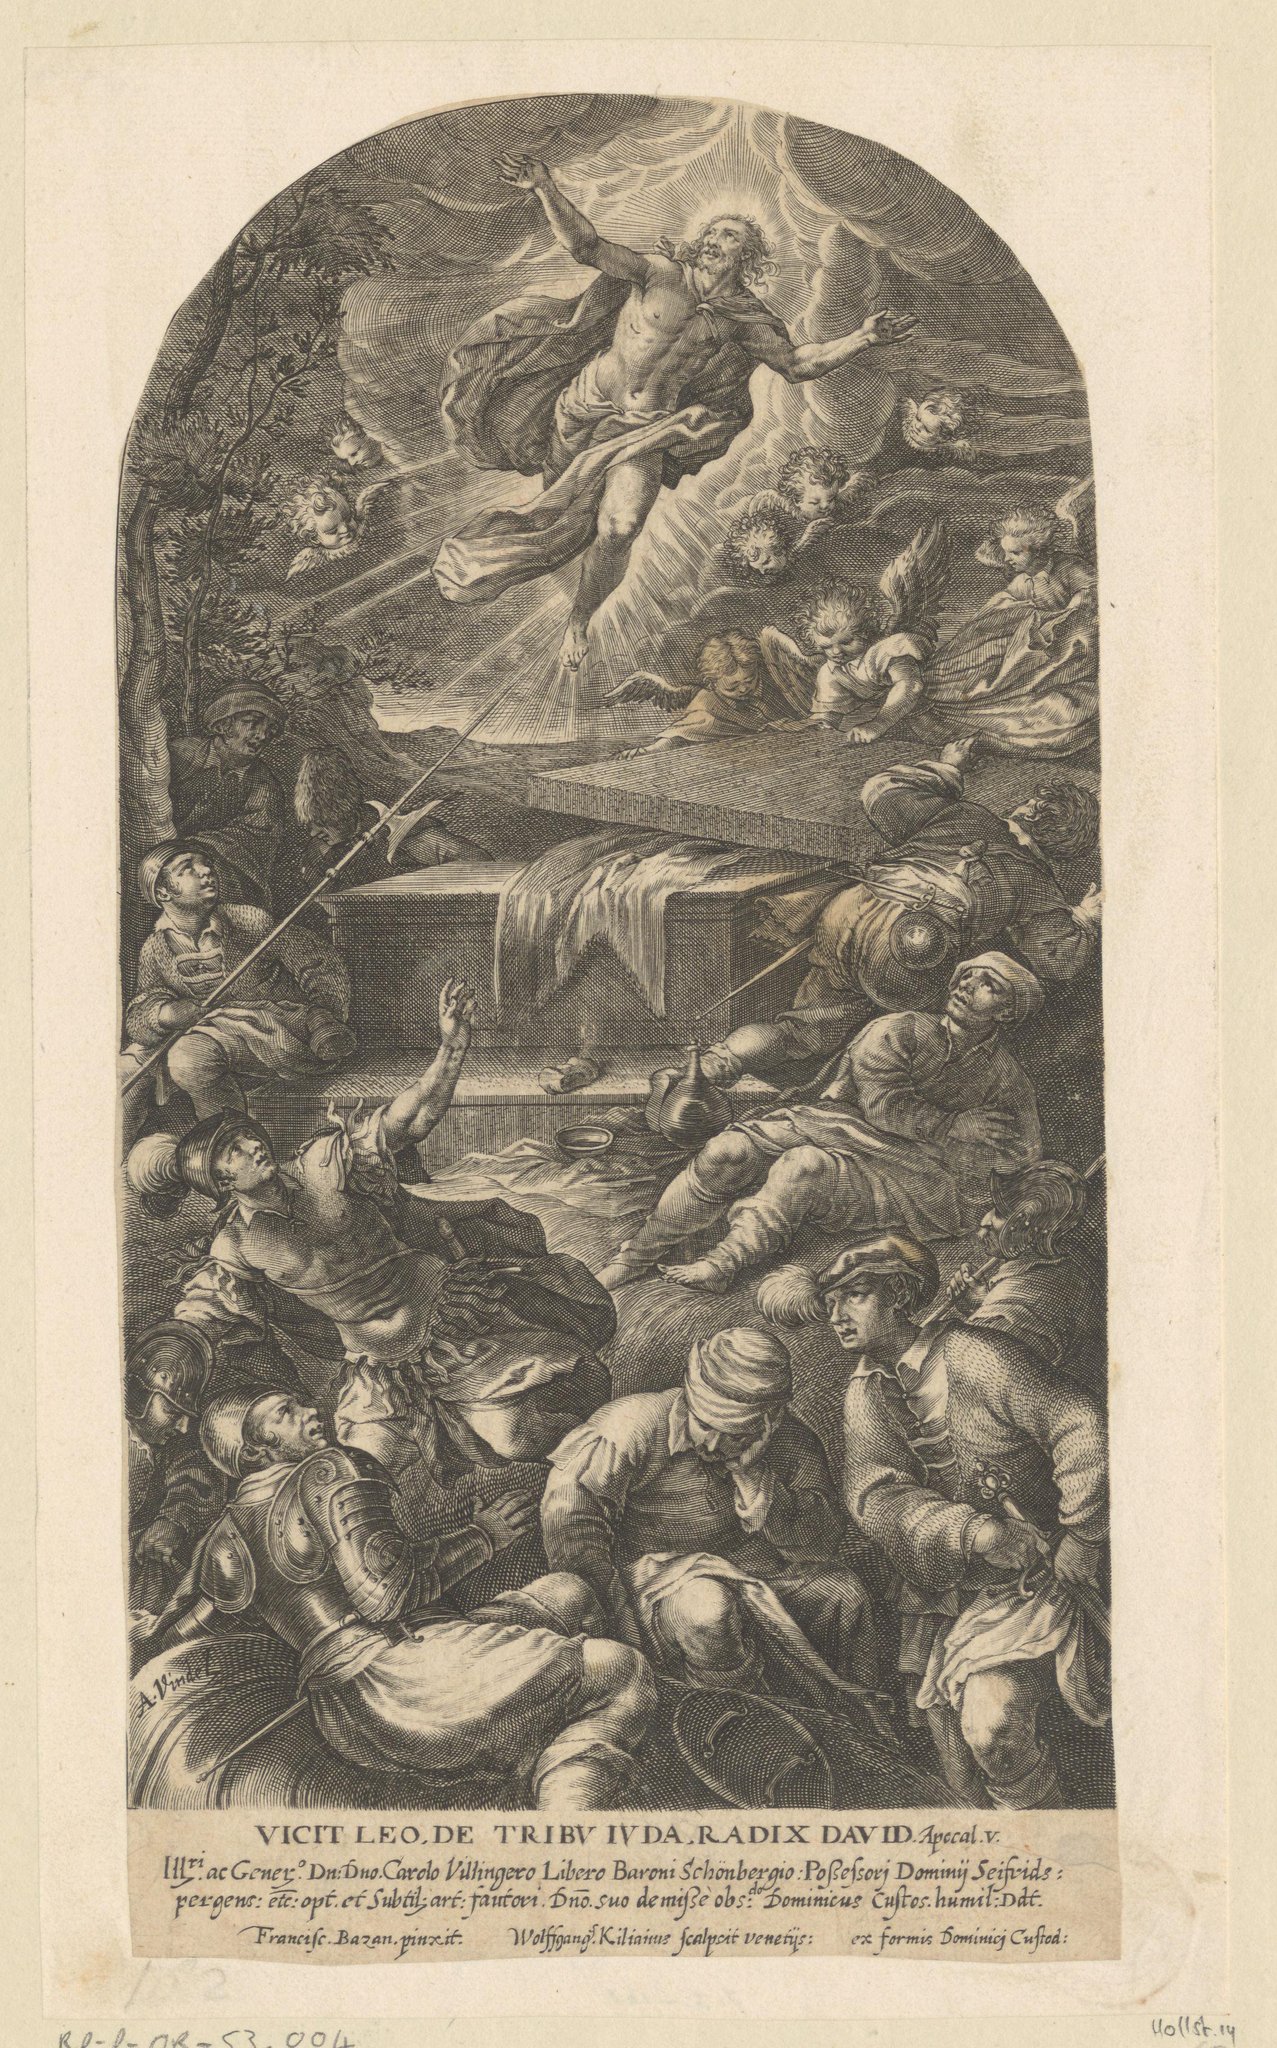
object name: print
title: Opstanding van Christus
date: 1591-1615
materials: paper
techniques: engraving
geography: venice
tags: christ, usually holding a banner, arises from the grave; often combined with sleeping and/or frightened soldiers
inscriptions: collector's mark: Lugt 240